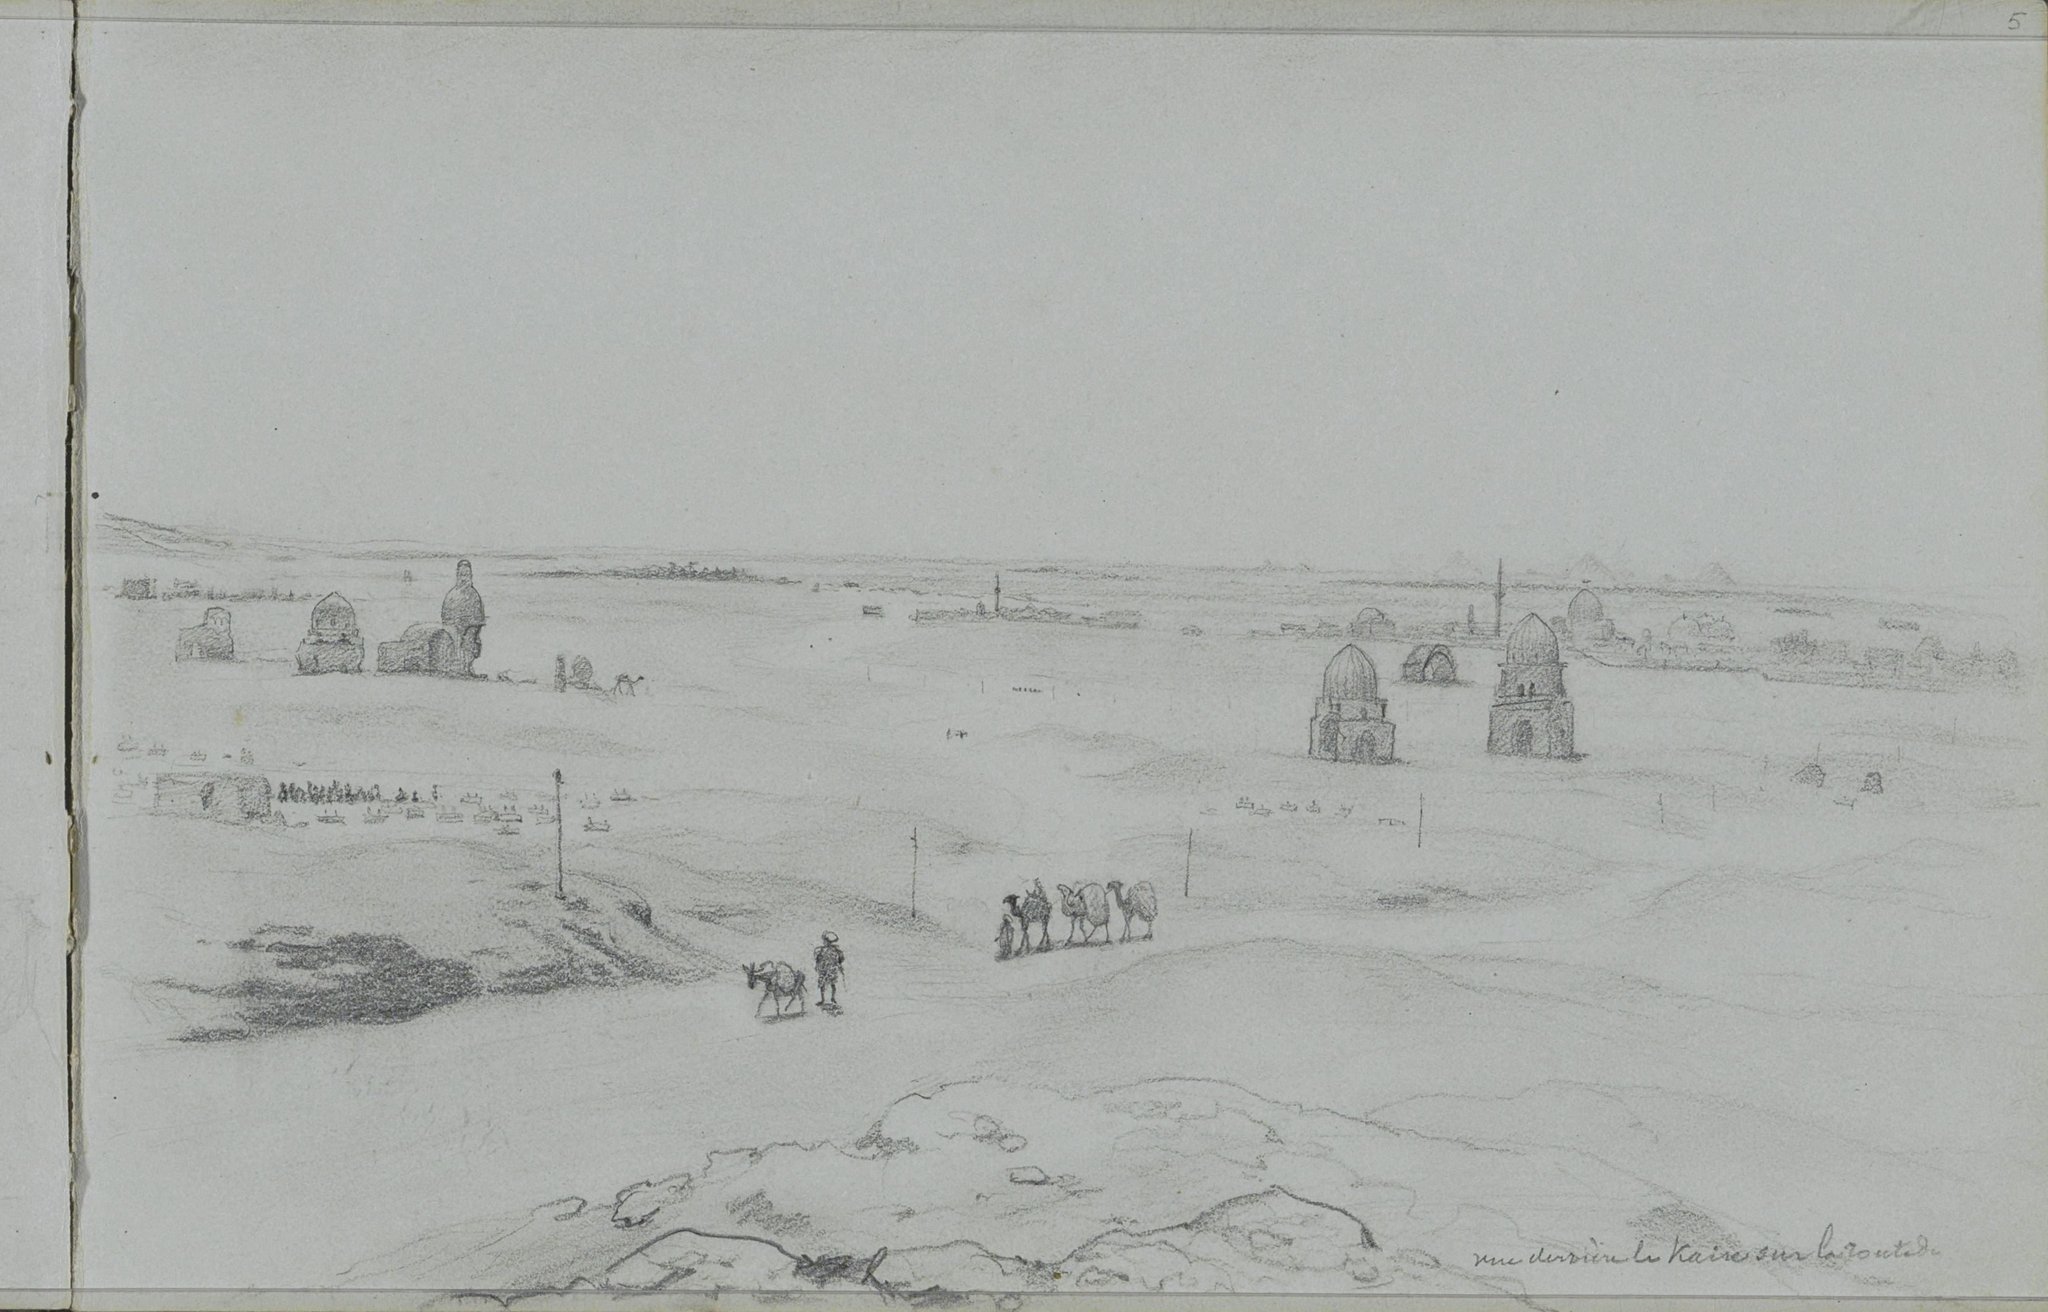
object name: sketchbook leaf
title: Graven van de Kaliefen in Caïro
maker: willem de famars testas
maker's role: draughtsman, painter, print maker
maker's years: 1834-1896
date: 1858-1860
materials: paper, pencil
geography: cairo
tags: grave-building, monumental tomb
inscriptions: annotation: ‘vue derriere le Kaire sur la route de’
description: Blad 5 recto uit een schetsboek met 23 bladen.